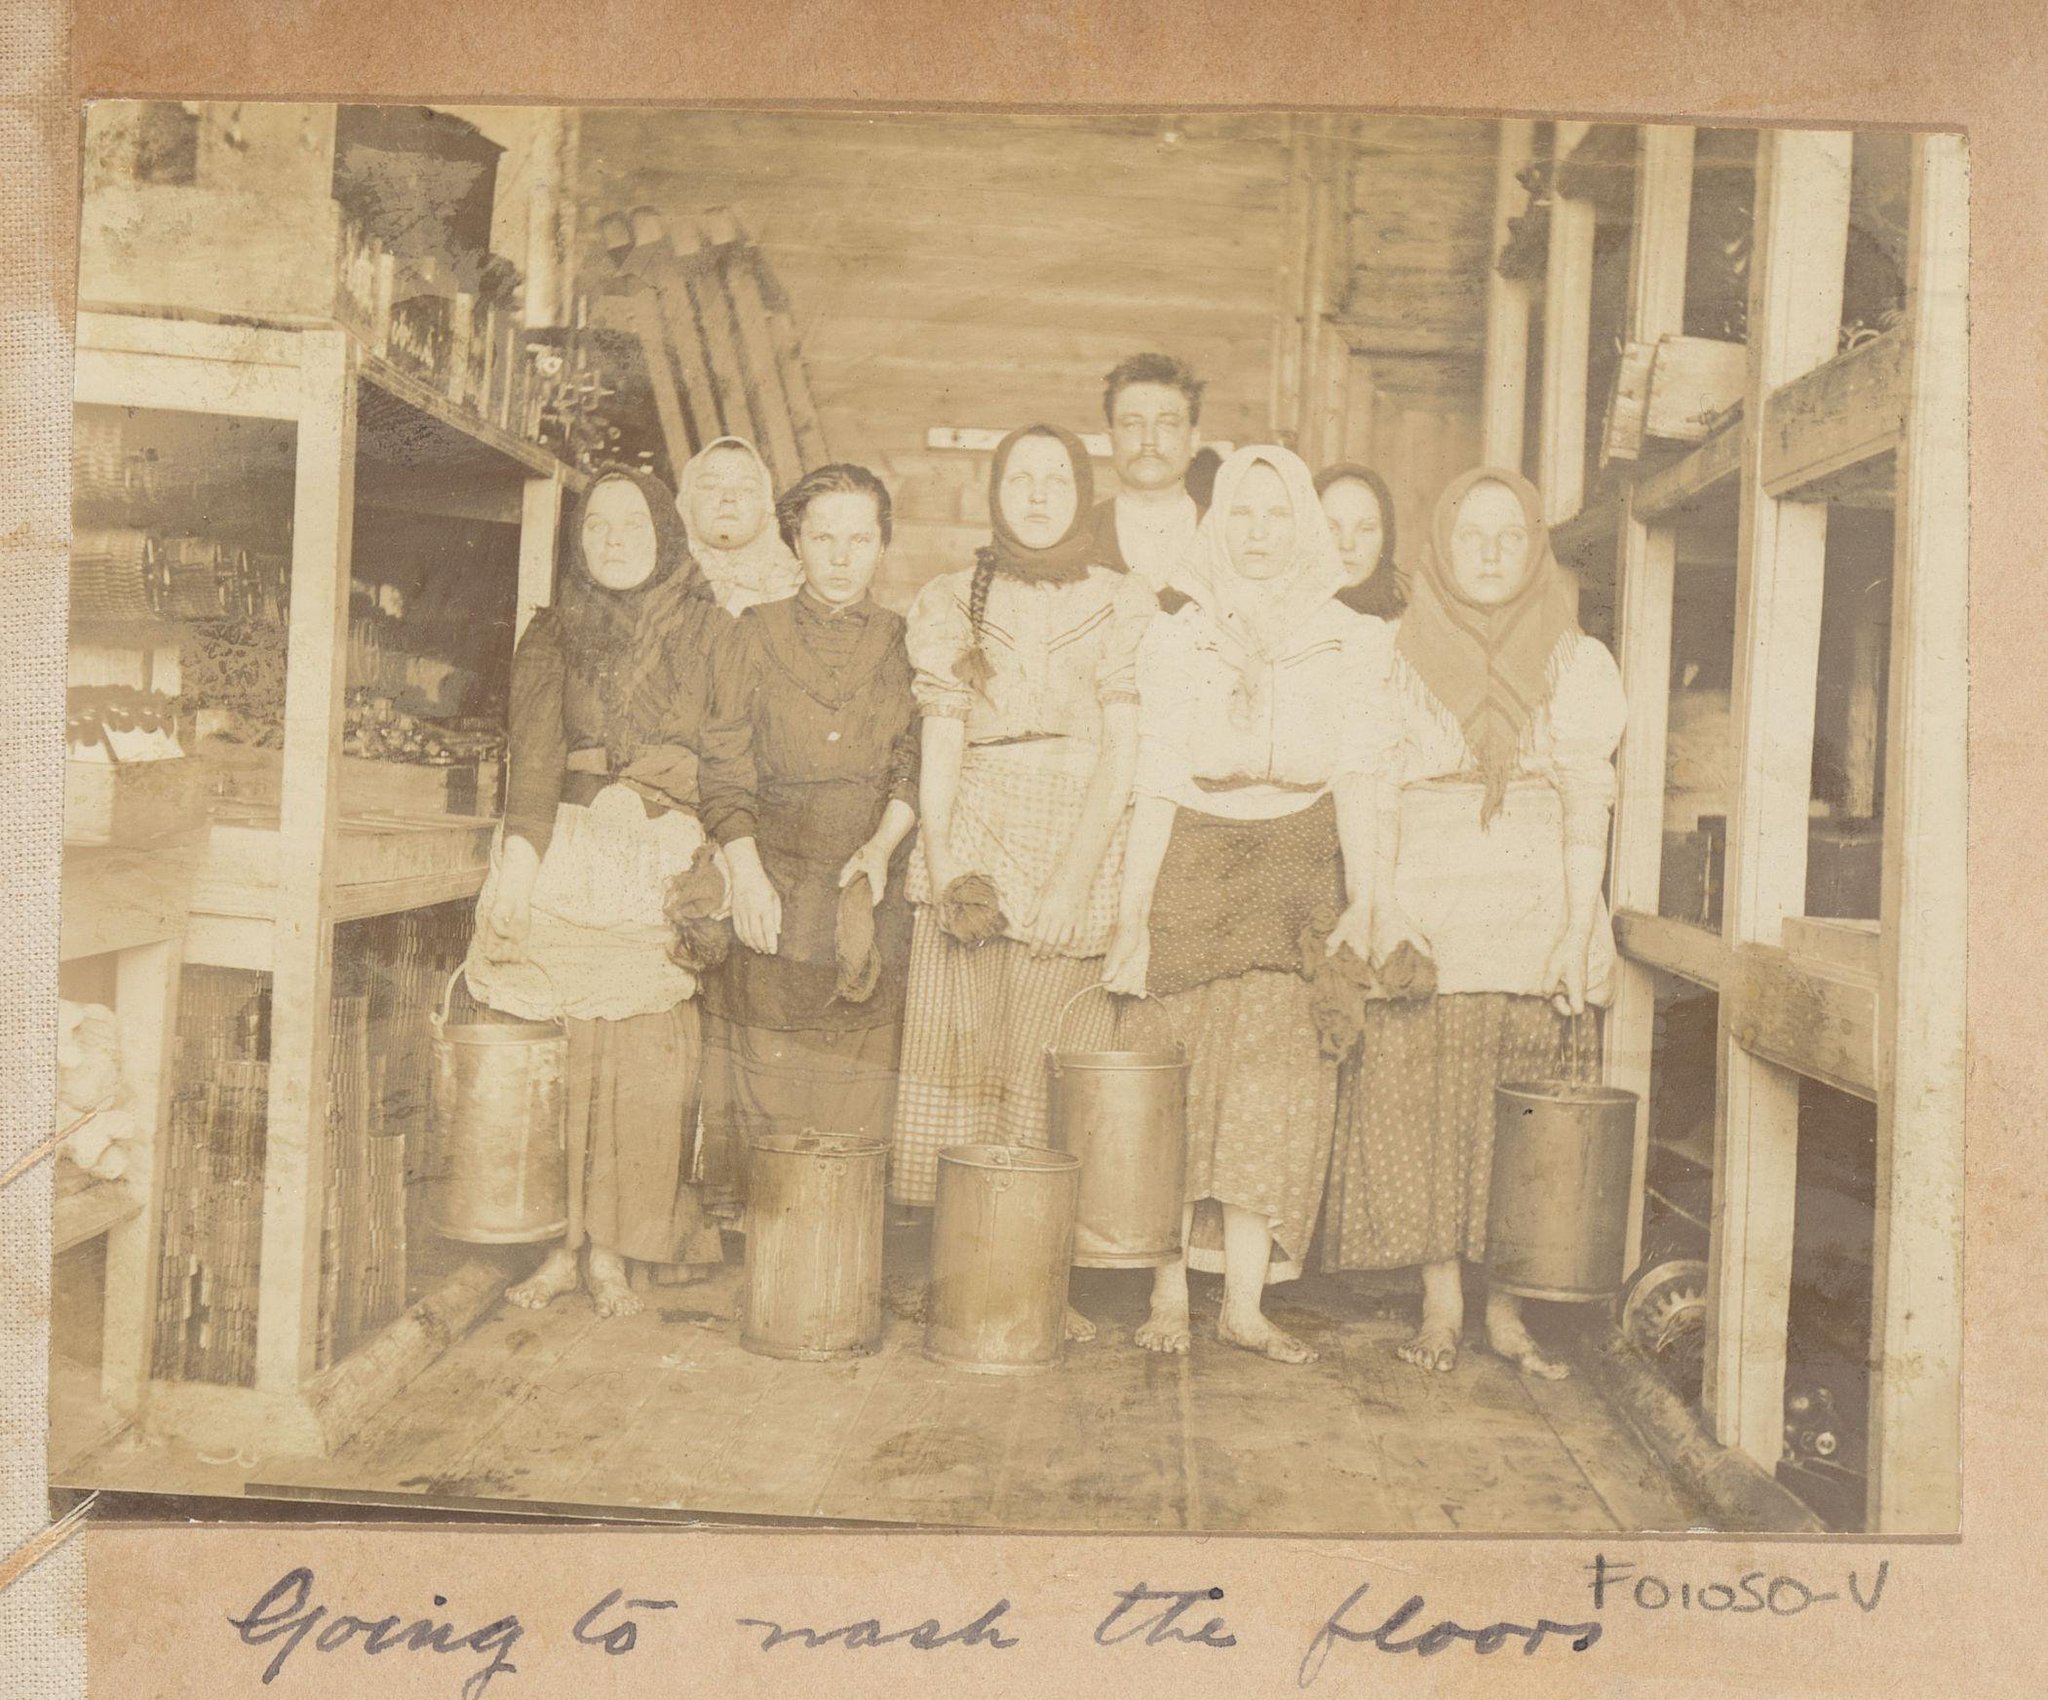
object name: photograph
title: Fabrieksarbeidsters met emmers te Sereda in Rusland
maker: joseph cheetham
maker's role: engineer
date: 1903-1904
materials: photographic support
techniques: gelatin silver print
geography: russia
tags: factory-interior, machine shop, barefoot, working class, labourers - aa - women, container of metal: bucket, can, canister, drum, tin, russia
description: Onderdeel van Fotoalbum van de Engelse familie Cheetham met opnames van hun verblijf in Rusland.